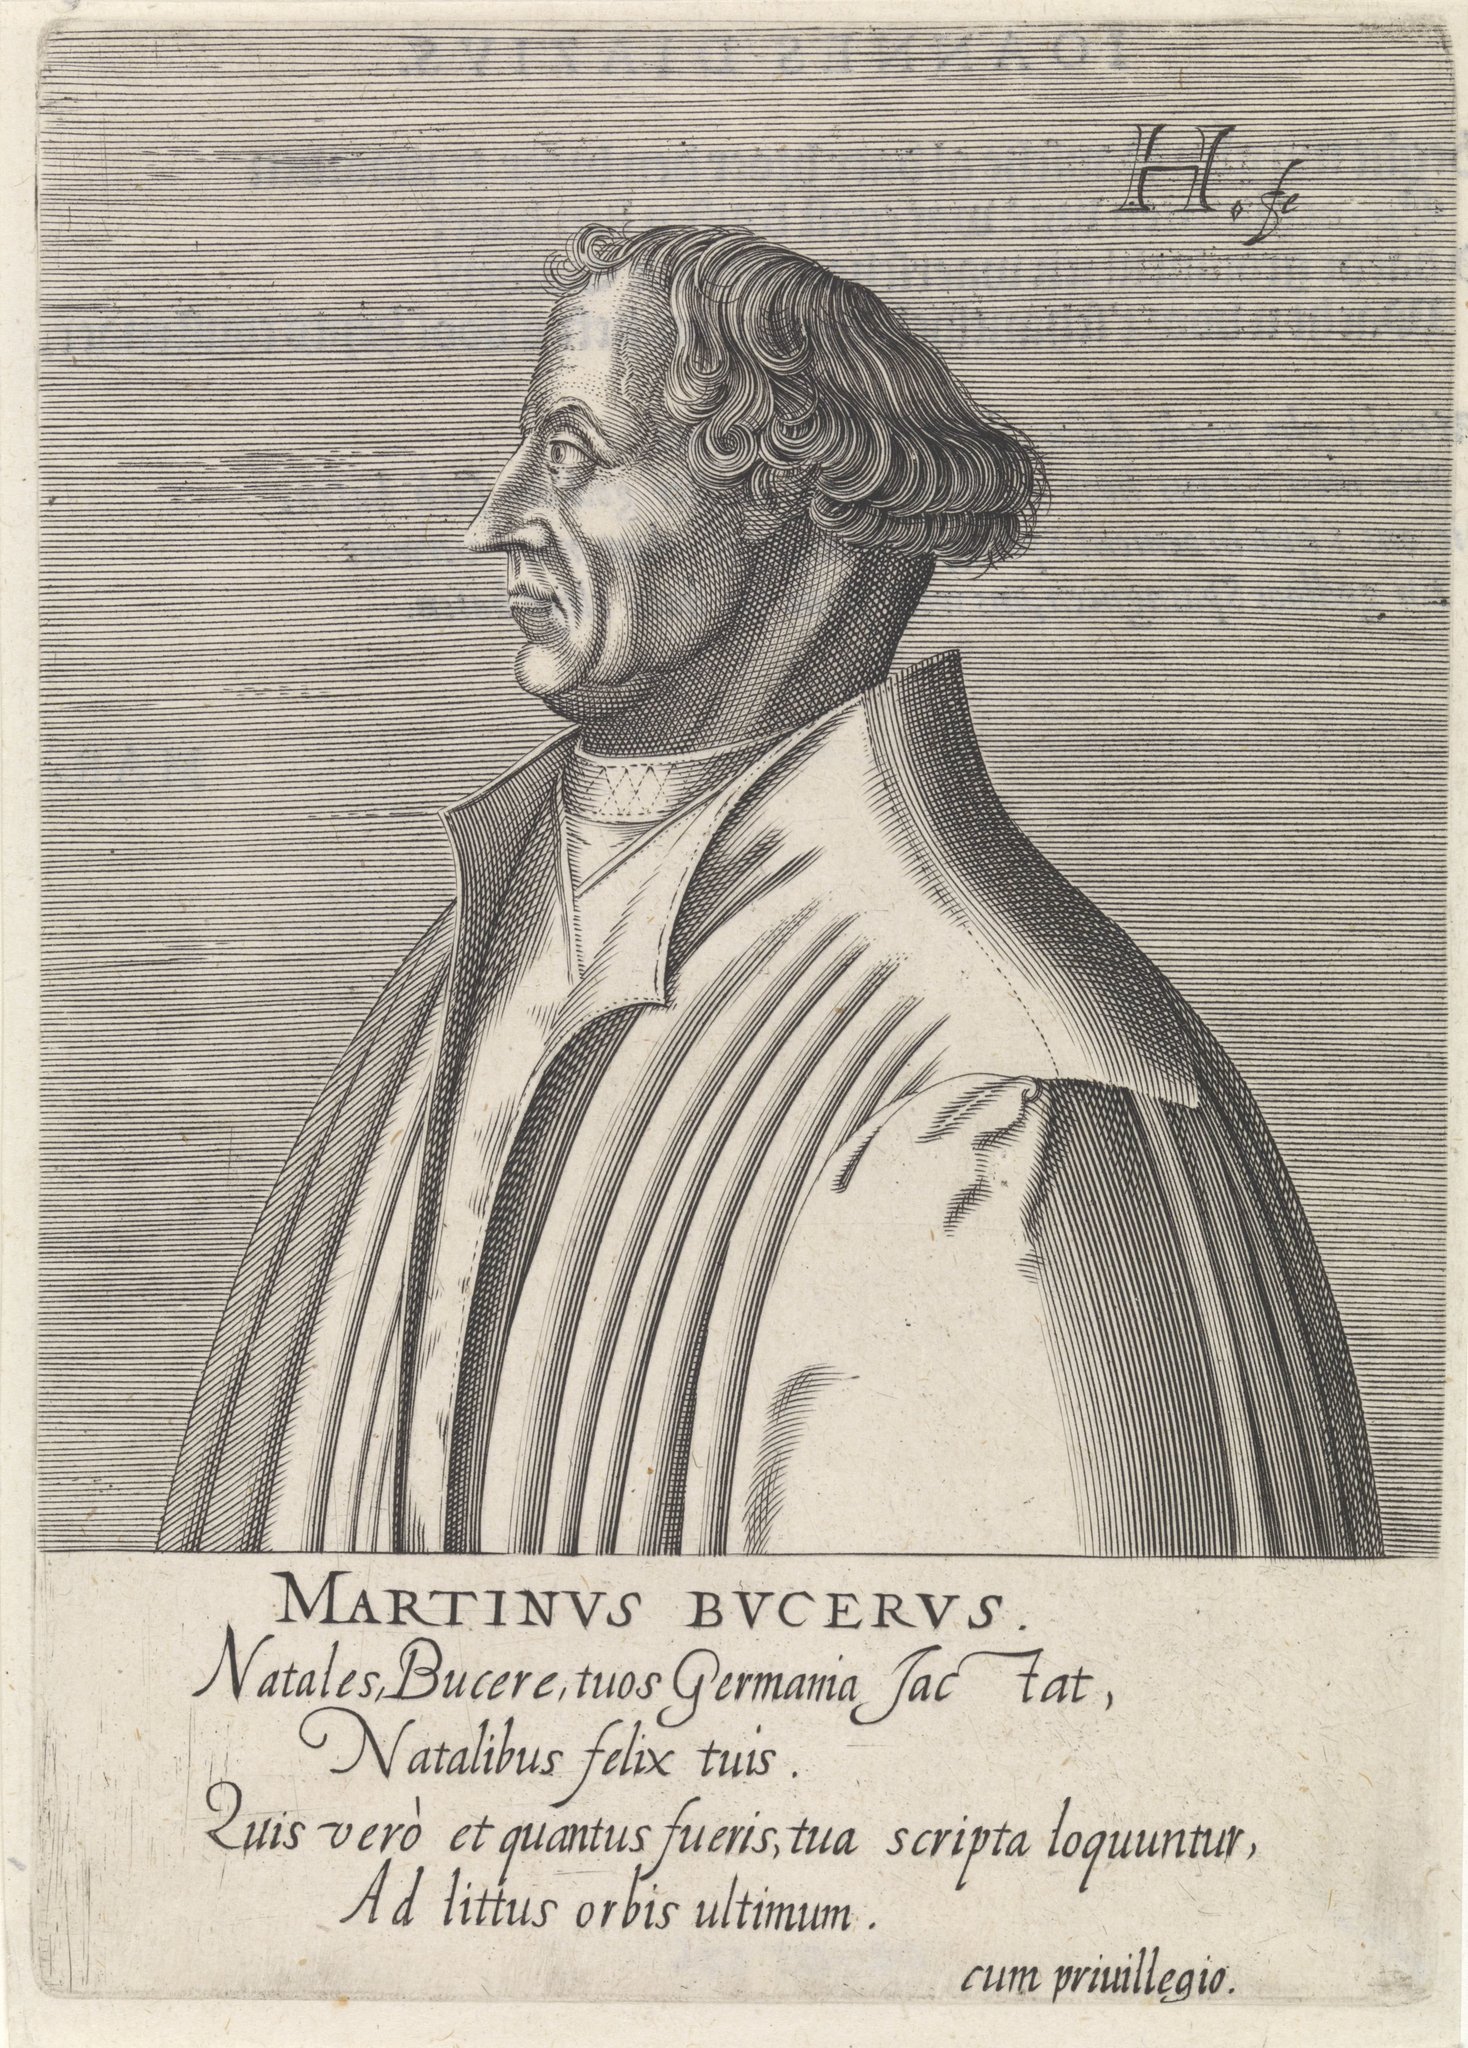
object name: print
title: Portret van Martinus Bucer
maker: hendrick hondius (i)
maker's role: draughtsman, print maker, publisher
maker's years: 1573-1650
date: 1599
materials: paper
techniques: engraving, letterpress printing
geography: the hague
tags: cambridge, theoloog, professor, martin bucer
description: Prent ook gebruikt als boekillustratie in: Jacob Verheiden, Præstantium aliquot theologorum, qui rom. antichristum præcipuè oppugnarunt, effigies. Den Haag: Hendrick Hondius I en Den Haag: B.C. Nieulandt, 1602-1603. Tevens: Arnhem, J.Janssen, 1604.